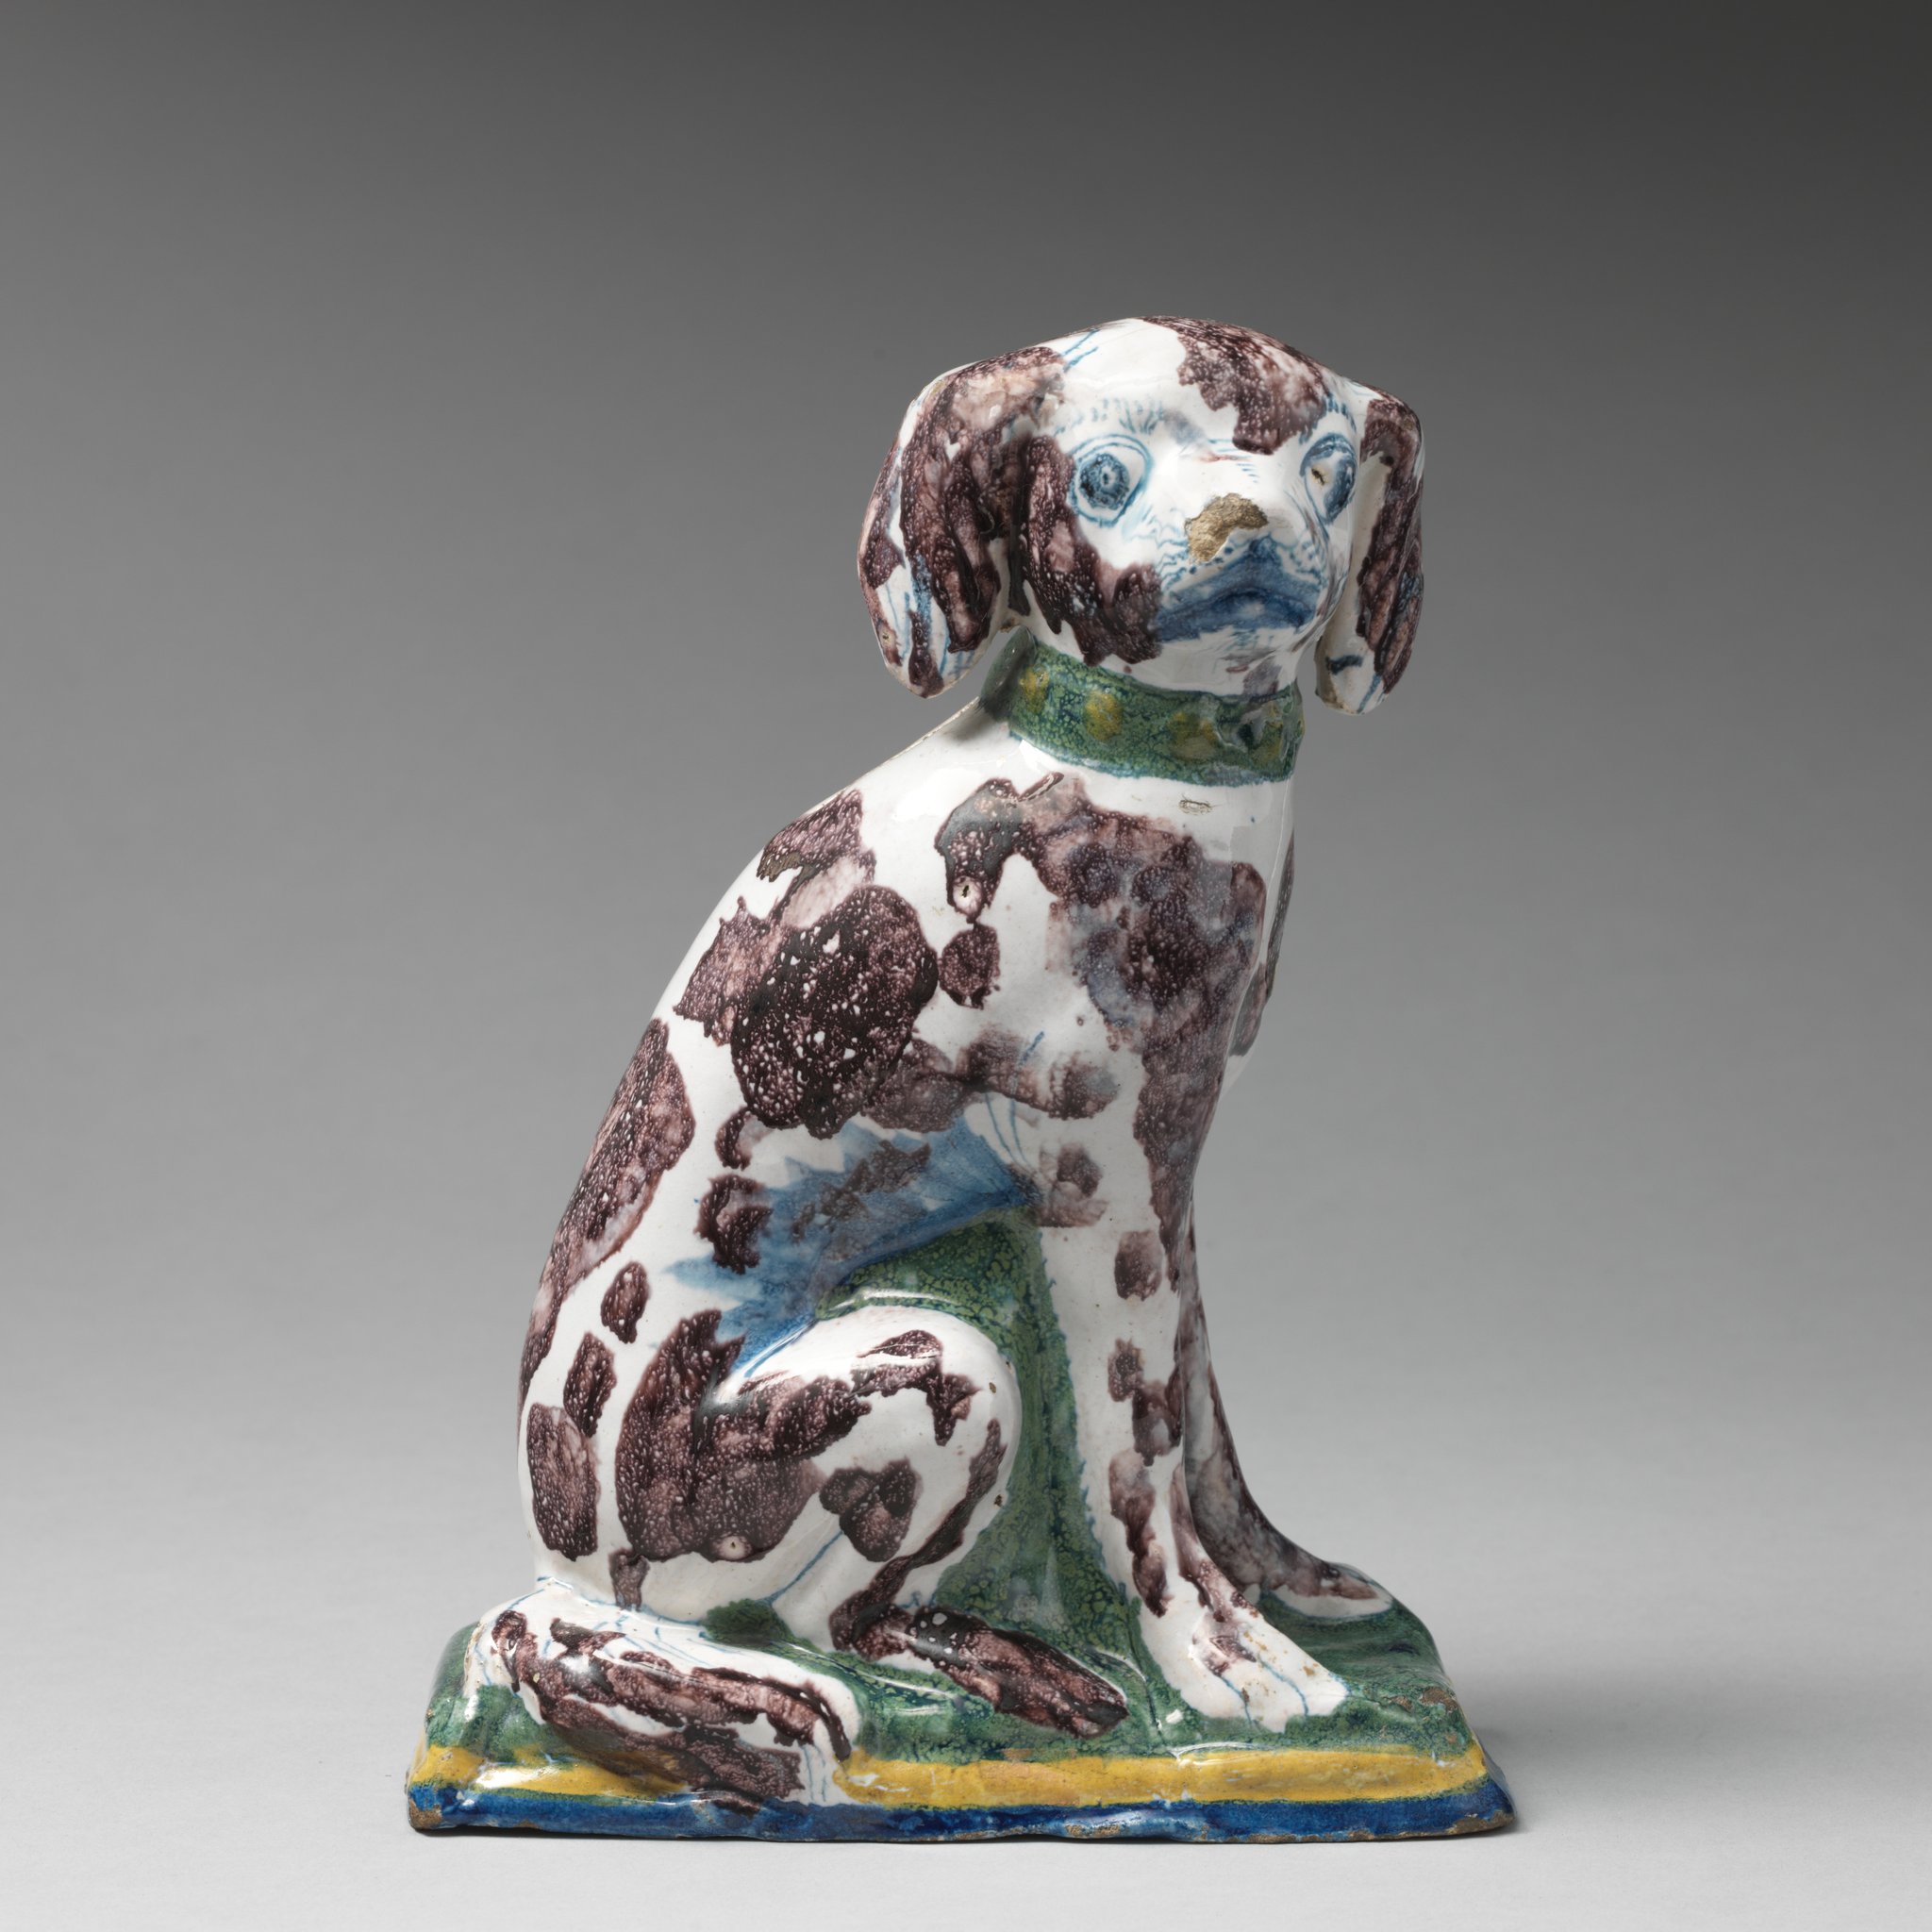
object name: money box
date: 1701-1800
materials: earthenware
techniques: glazing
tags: dogs